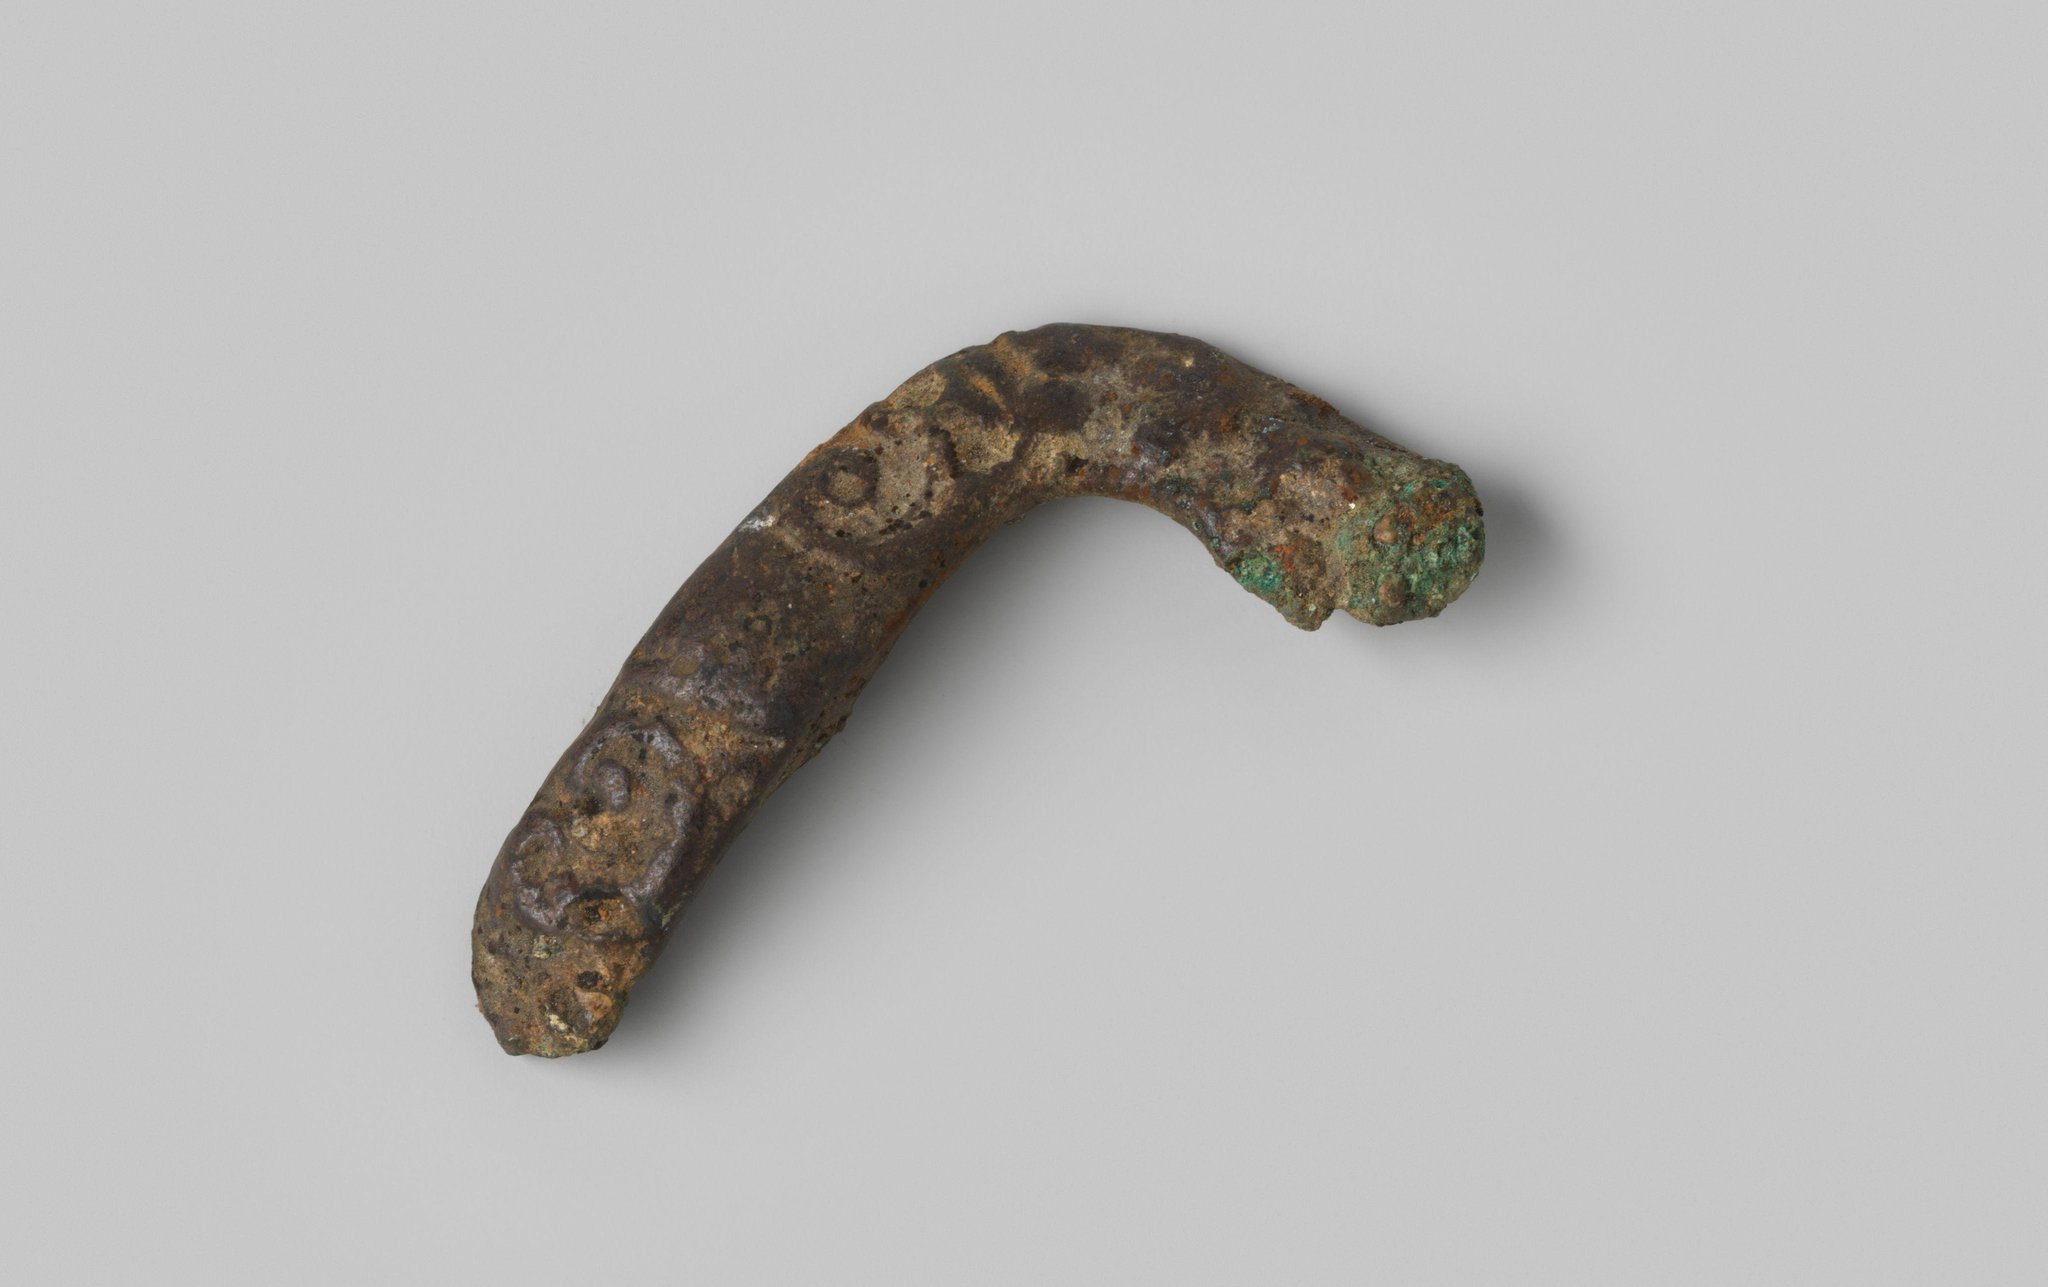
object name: shoe buckle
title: Fragment schoengesp uit het wrak van de Oost-Indiëvaarder Hollandia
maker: Anonymous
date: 1700-1743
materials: copper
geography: netherlands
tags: verenigde oostindische compagnie, hollandia (schip), annet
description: Buckle, chape buckle, shoe buckle; fragment of ring, moulded, eroded, sim. NG 1980-27H602.